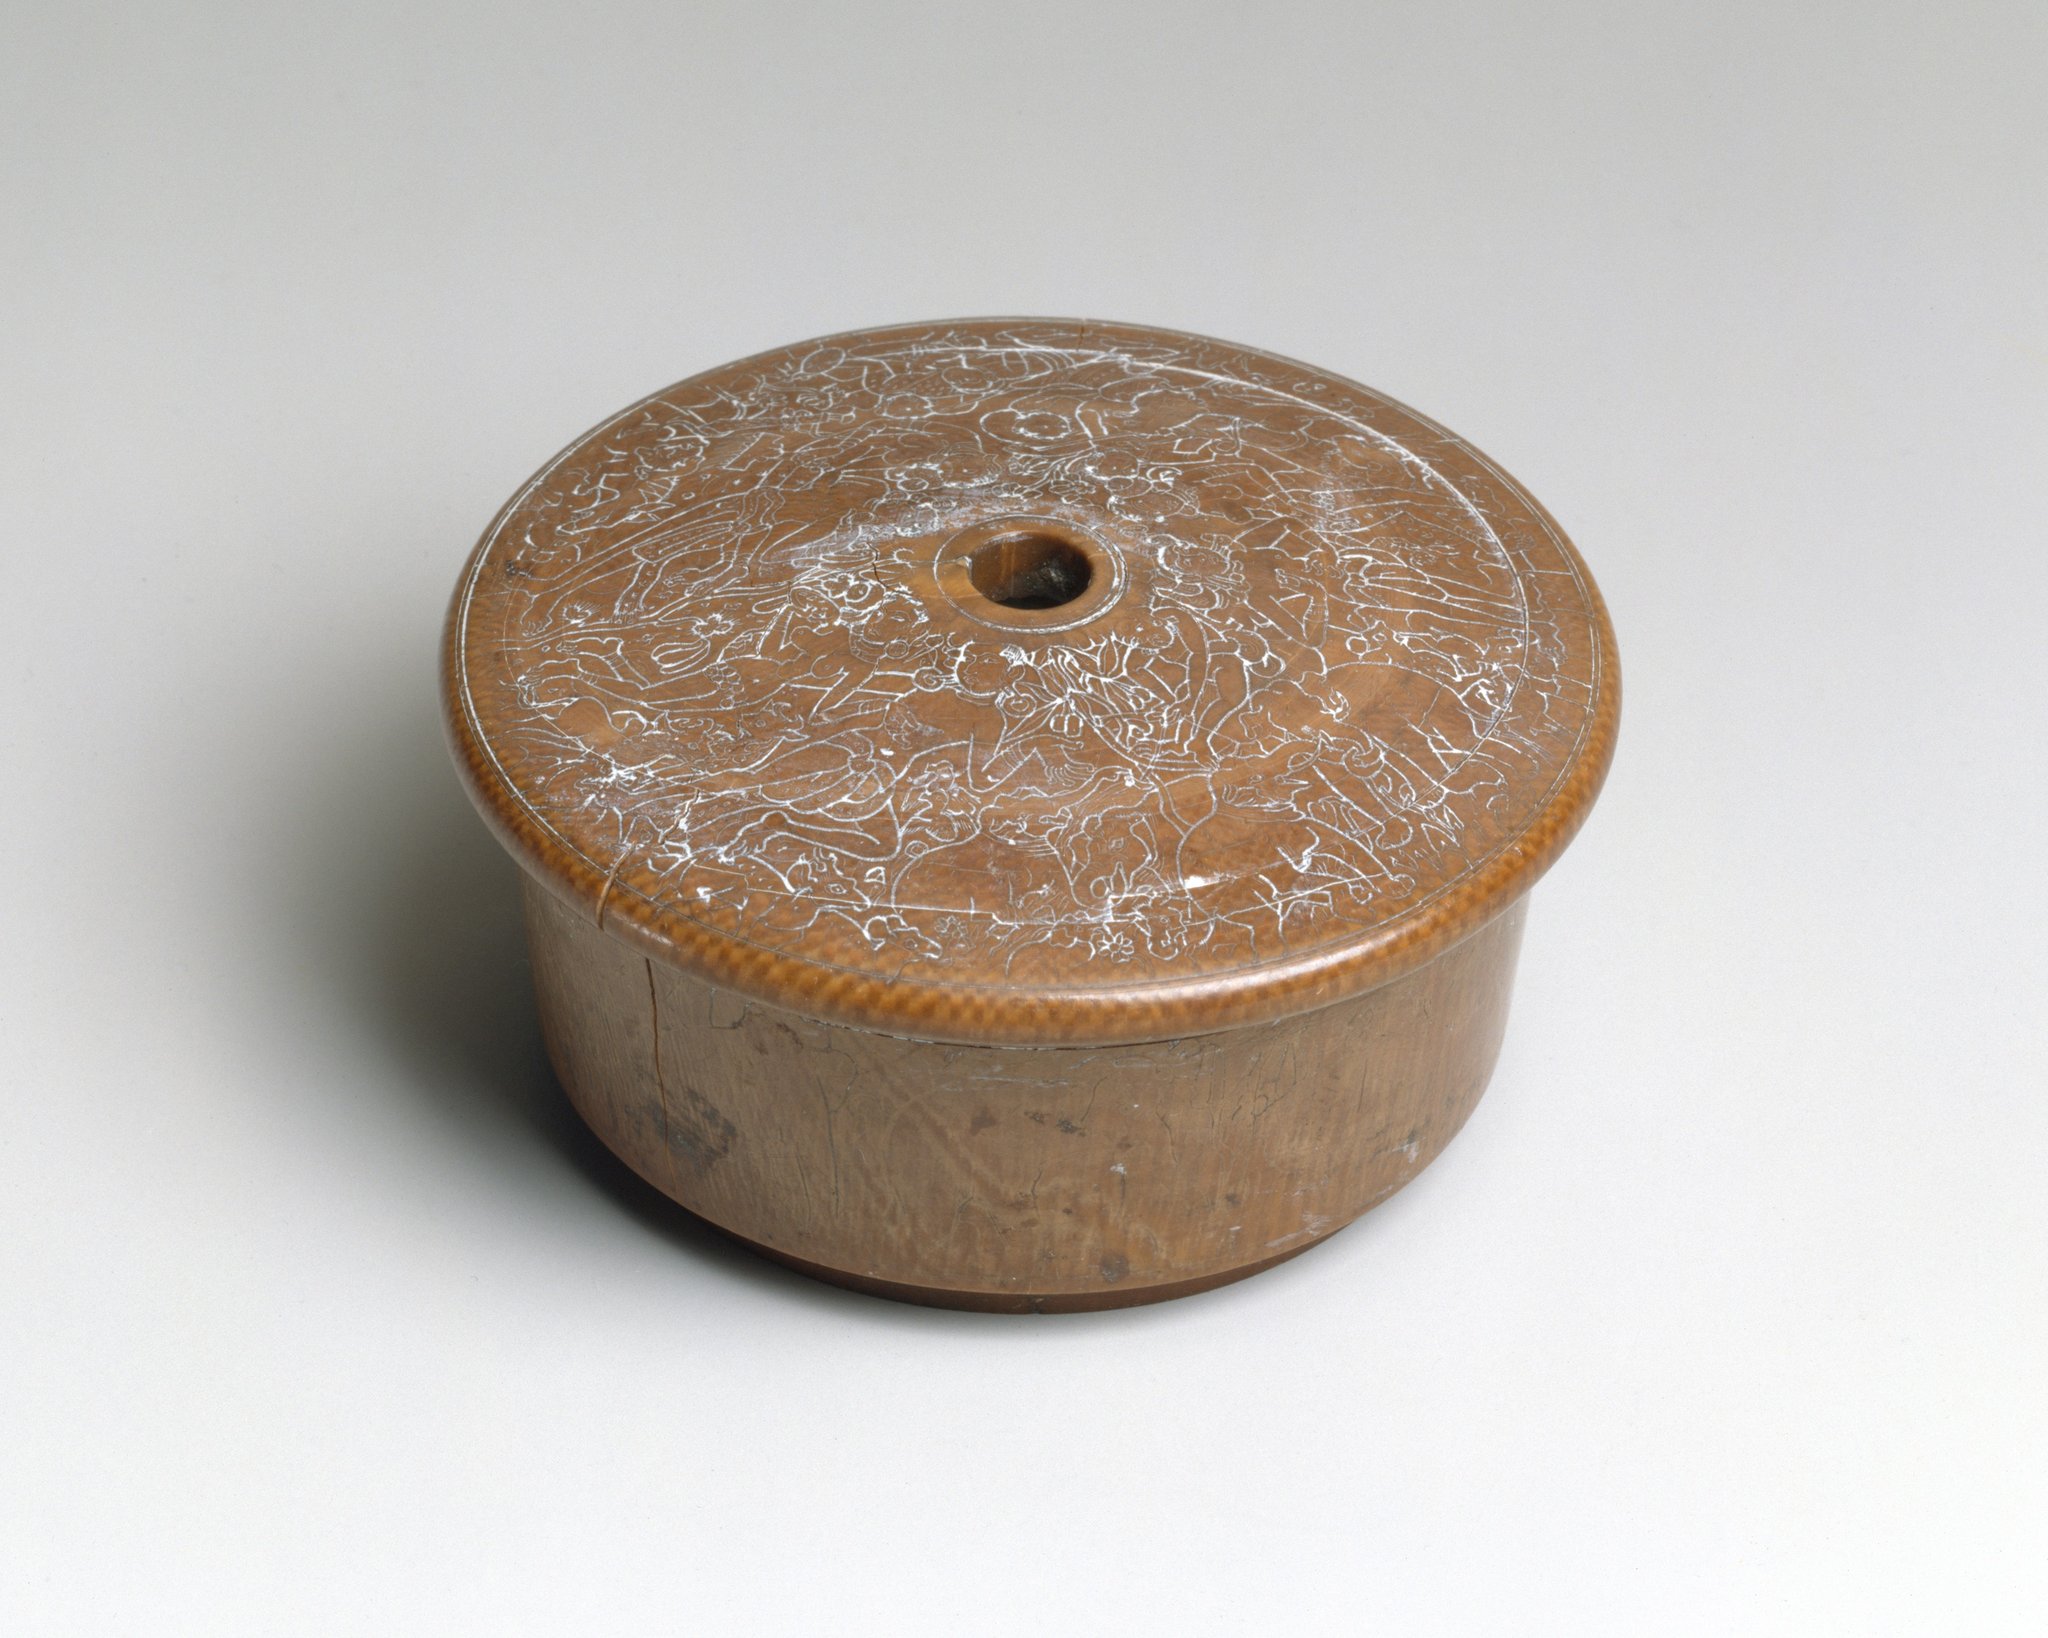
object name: box with lid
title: Box Lid with Incised Figural Decoration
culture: indian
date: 201-400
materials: ivory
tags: early andhra,elephants